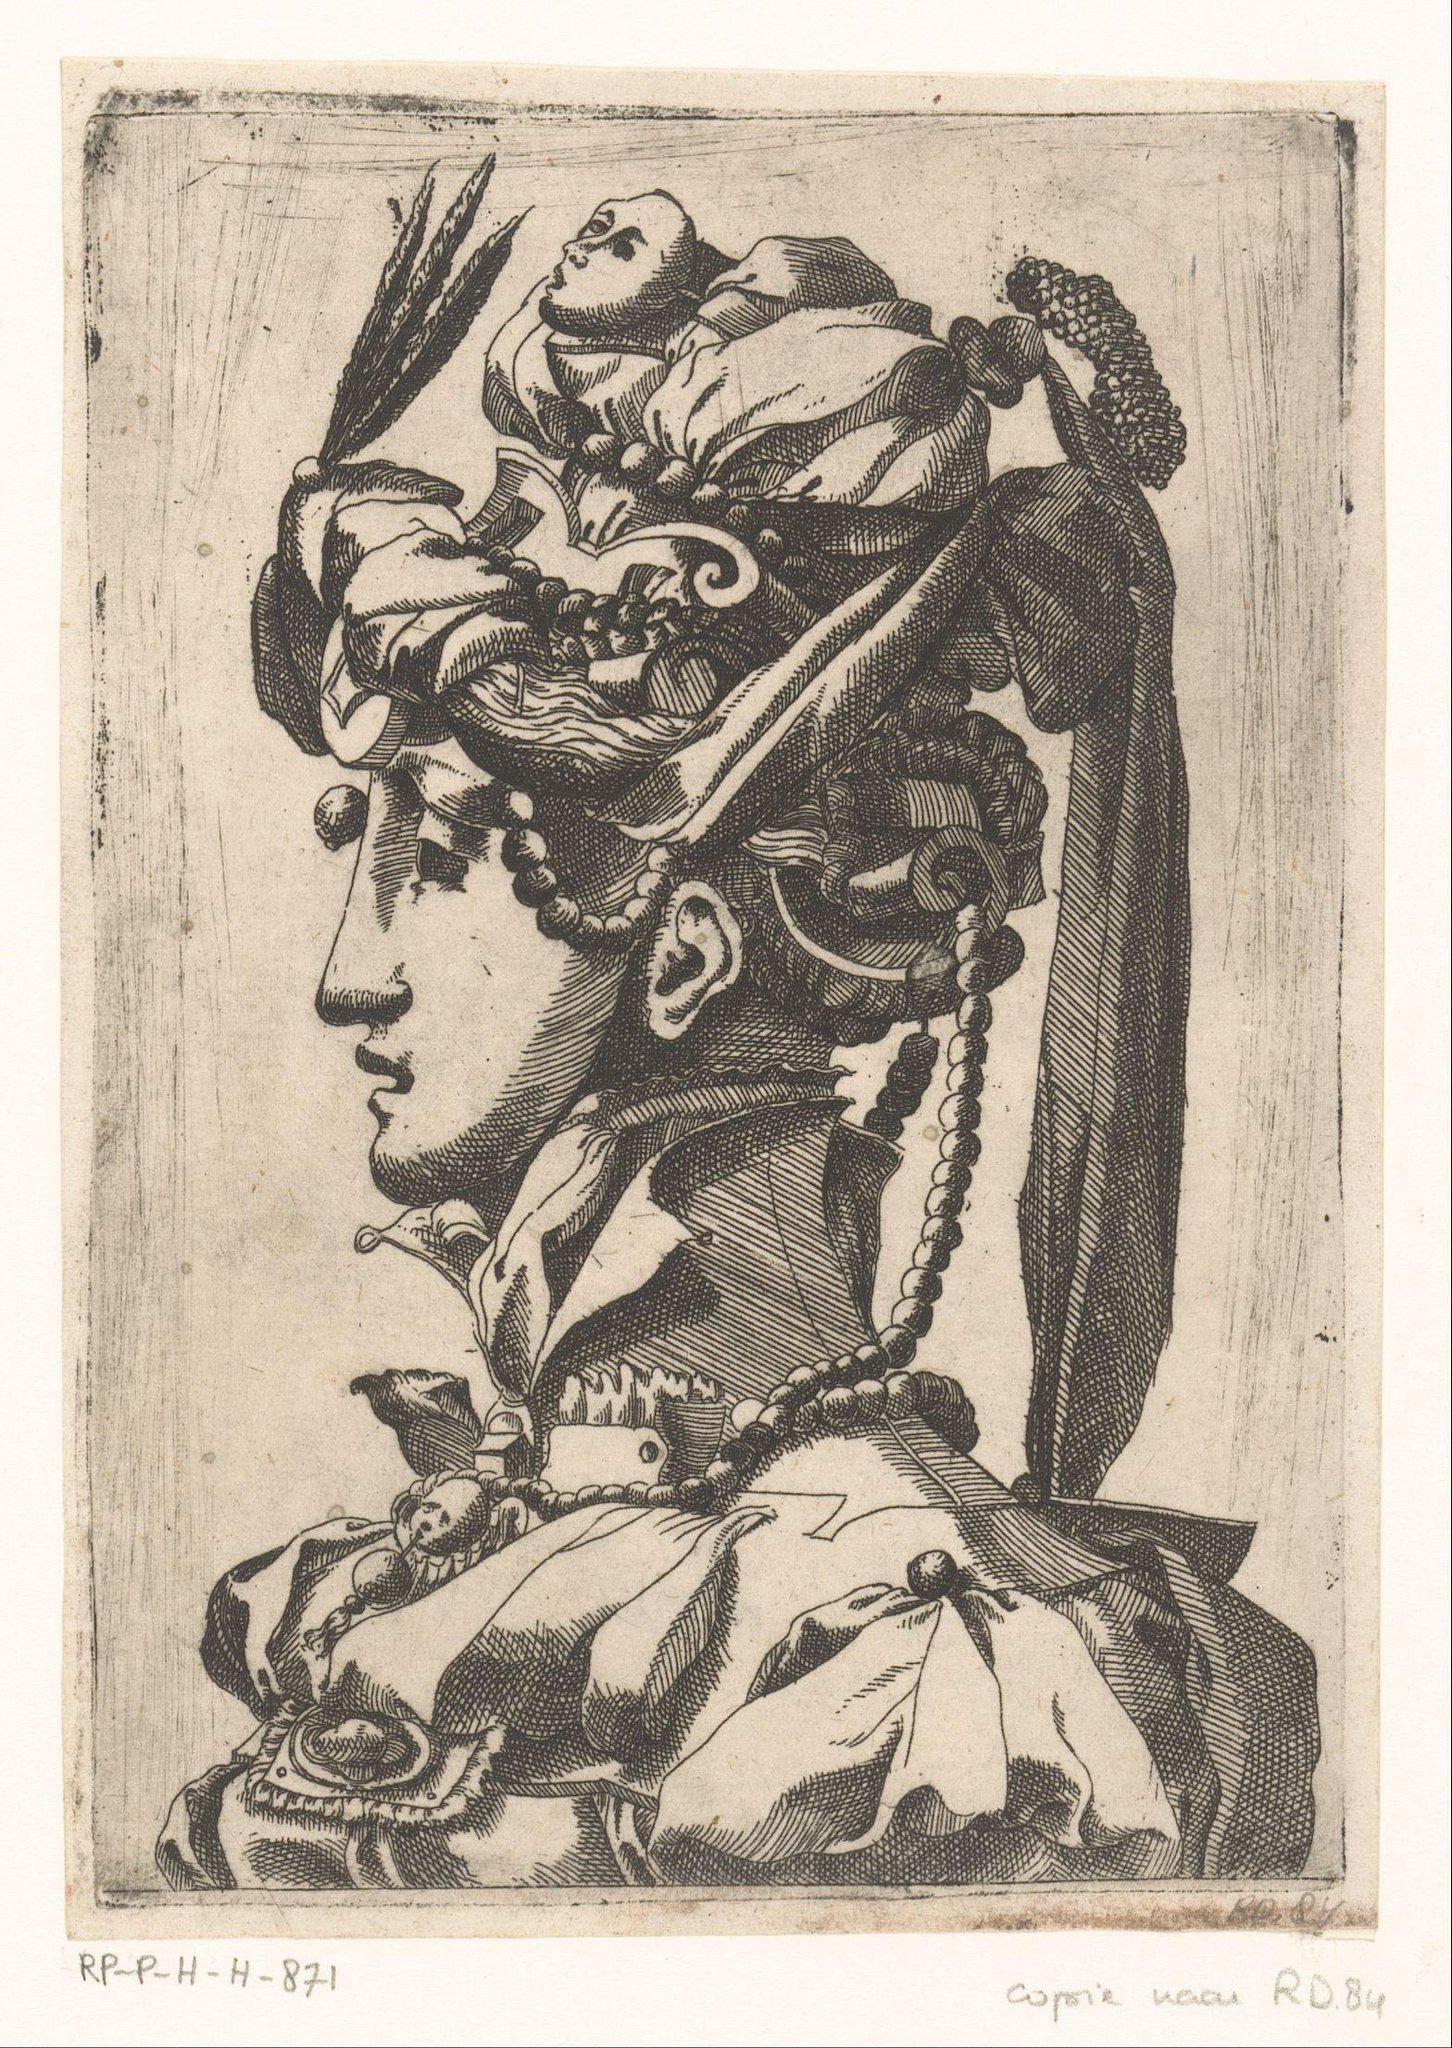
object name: print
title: Coiffures ou masques d'hommes et de femmes pour des ballets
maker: Anonymous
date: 1535-1598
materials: paper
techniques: etching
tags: mask, head-gear, the arts of the stage: ballet, theatre, musical drama, motion picture, fantasy costume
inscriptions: collector's mark: Lugt 11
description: Kopie naar een prent uit een serie van twaalf prenten met mannen- en vrouwenkostuums en haardrachten voor het ballet, getiteld 'Coiffures ou masques d'hommes et de femmes pour des ballets', naar ontwerp door Rosso Fiorentino. Betreft een spiegelbeeldige kopie van de linkerkant van Dumesnil 84.